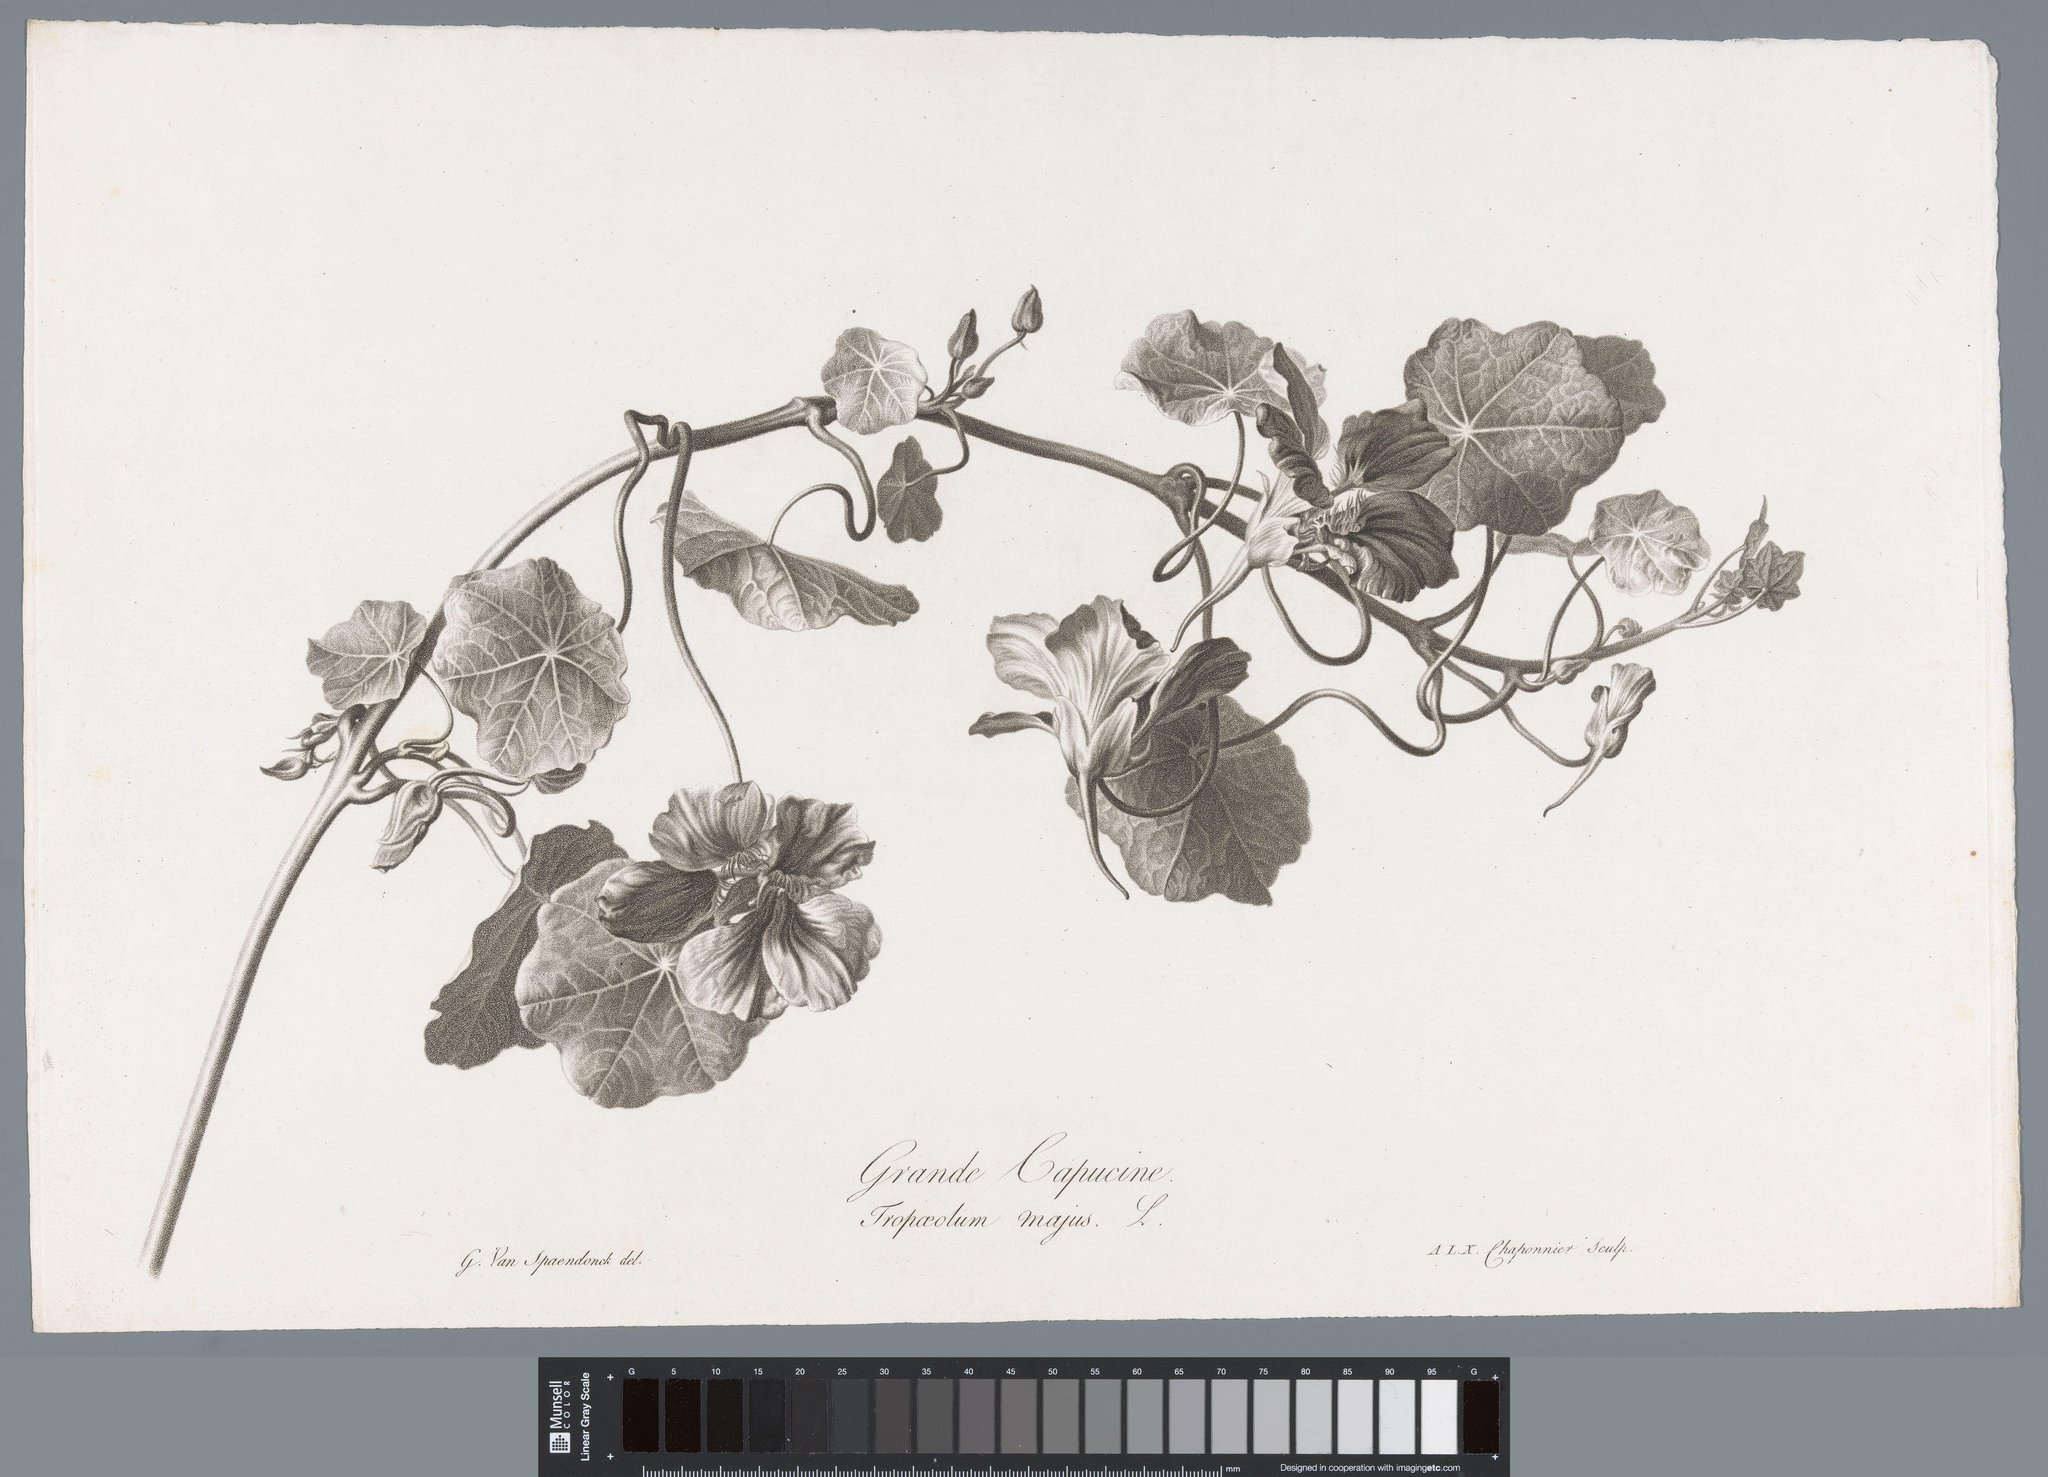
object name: ornament print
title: Grande Capucine / Tropaeolum Majus L.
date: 1799-1801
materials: paper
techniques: engraving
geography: paris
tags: flowers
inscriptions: collector's mark: Lugt 2228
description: De serie Fleurs dessinées d'après nature (...) bestaat uit 24 prenten verdeeld over zes omslagen. Het Rijksprentenkabinet heeft 23 prenten in zes omslagen in bezit. De verdeling over de omslagen lijkt willekeurig. Zie RP-P-1909-4220 t/m 4242 en RP-P-2016-53 t/m 58.